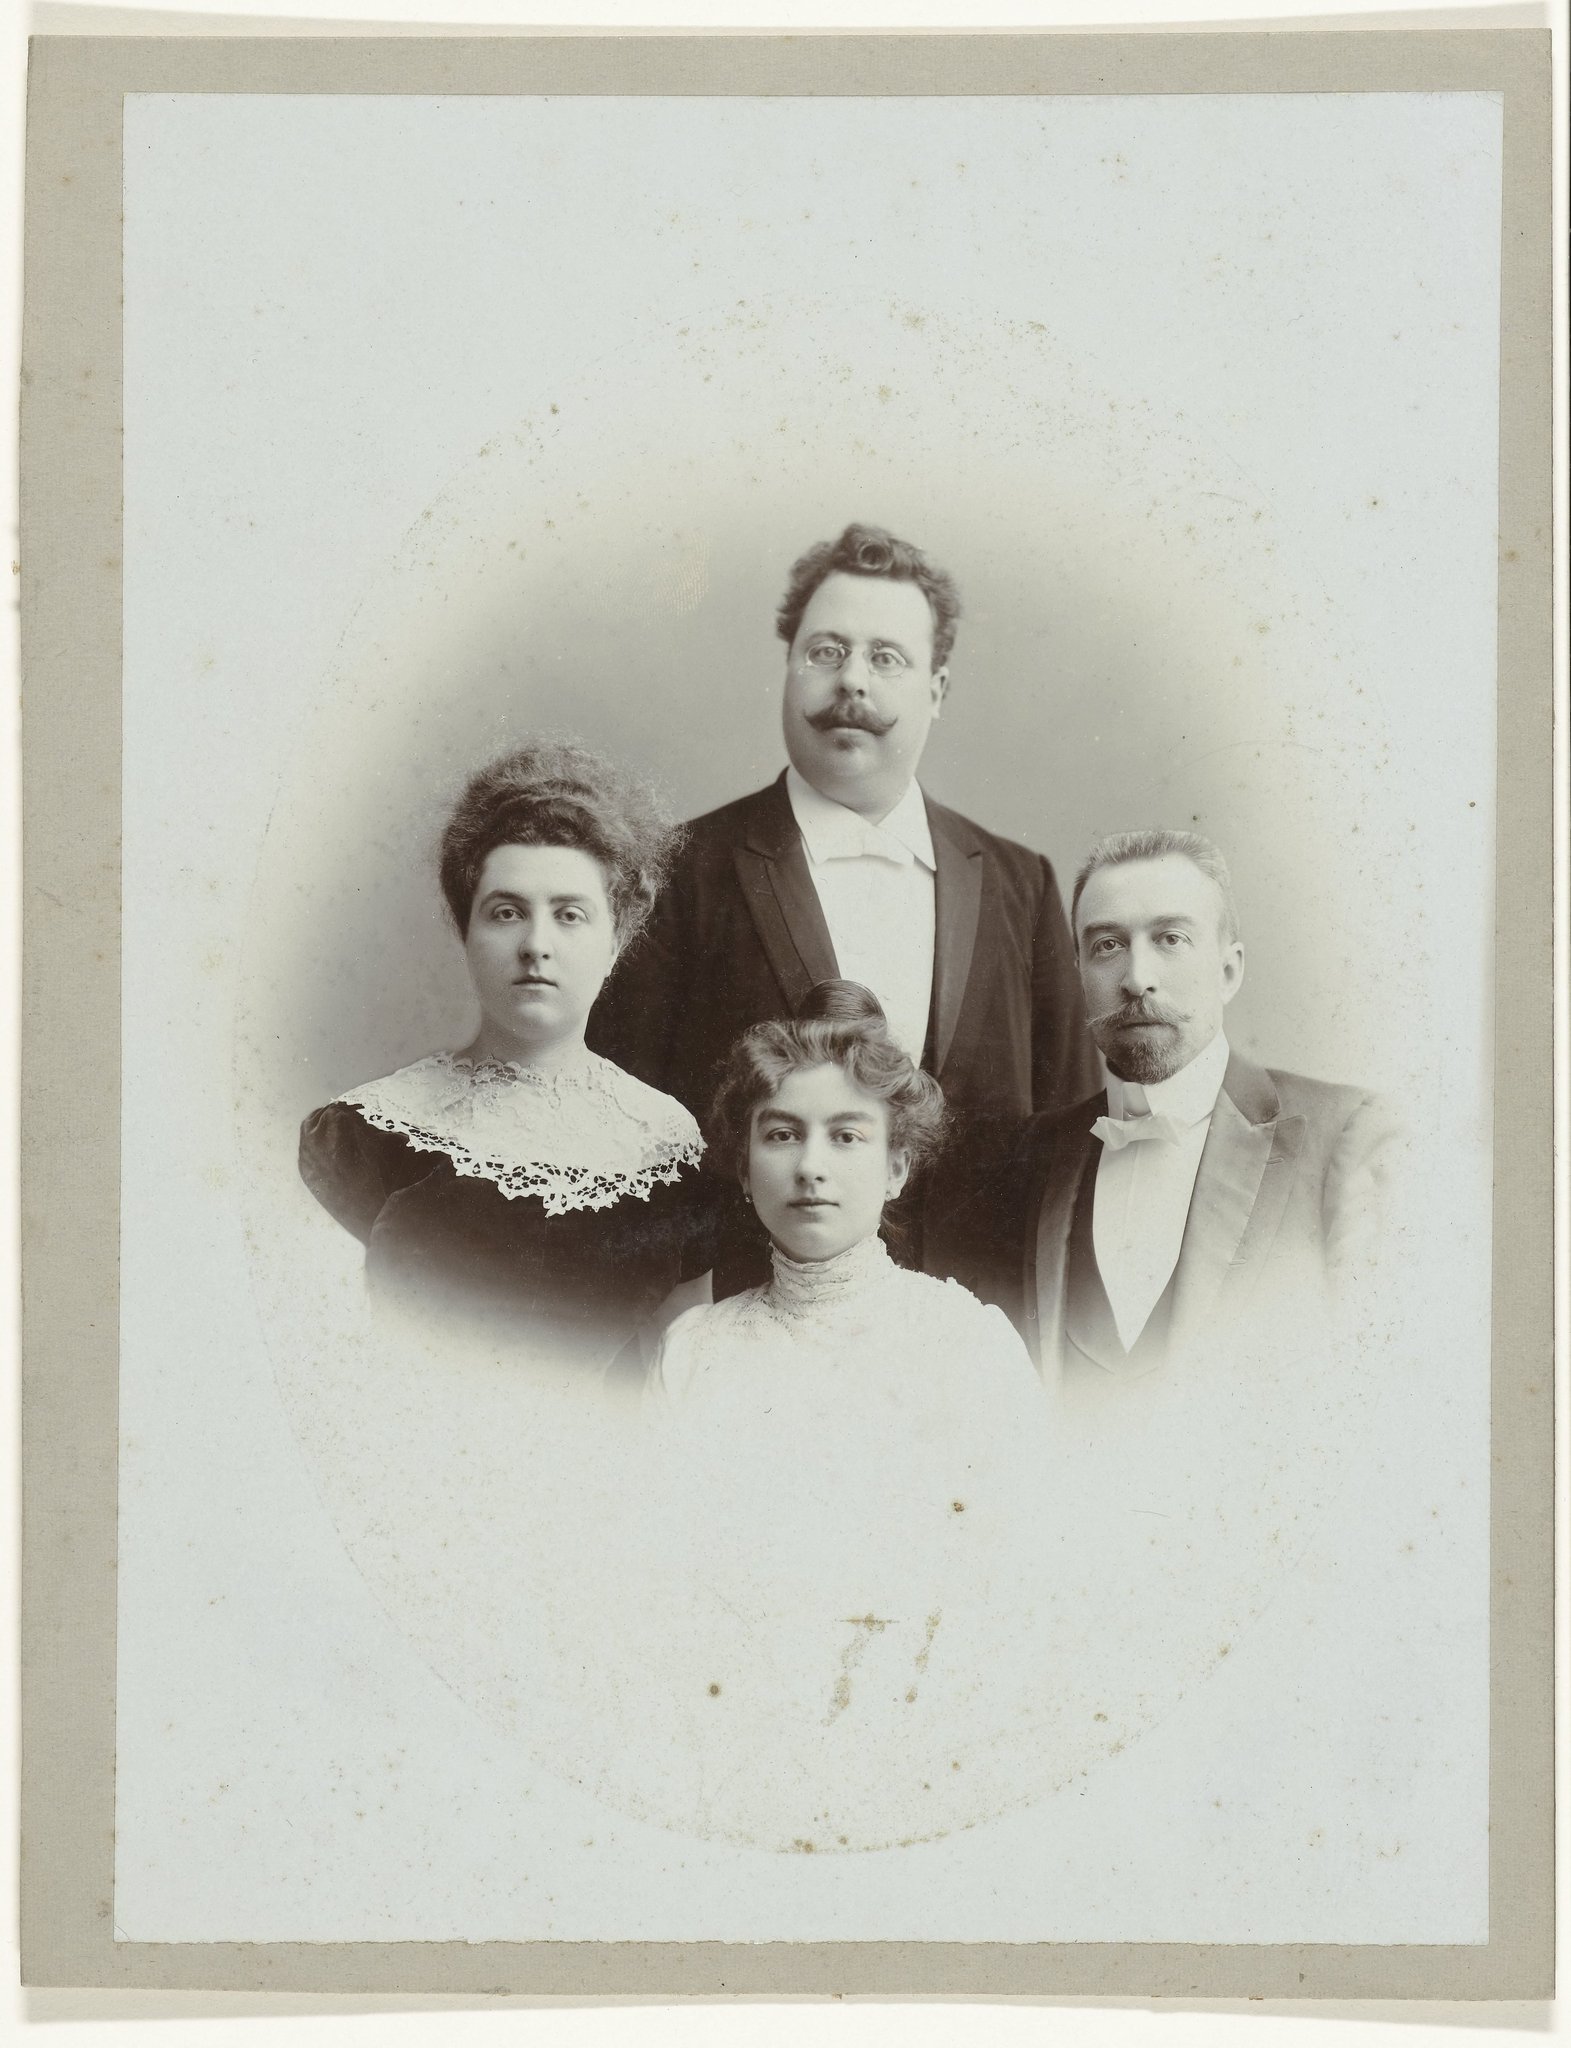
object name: photograph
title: Hollandsch vocaal kwartet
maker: jean daniel matthieu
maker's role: fotograaf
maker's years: 1865-1926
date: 1880-1920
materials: cardboard, paper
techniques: collodion silver print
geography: amsterdam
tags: anonymous historical persons portrayed in a group, in a group-portrait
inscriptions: stamp: ‘Fotografie Artistique J.D. Matthieu Ceintuurbaan 187 Amsterdam’, annotation: ‘Hollandsch vocaal kwartet’